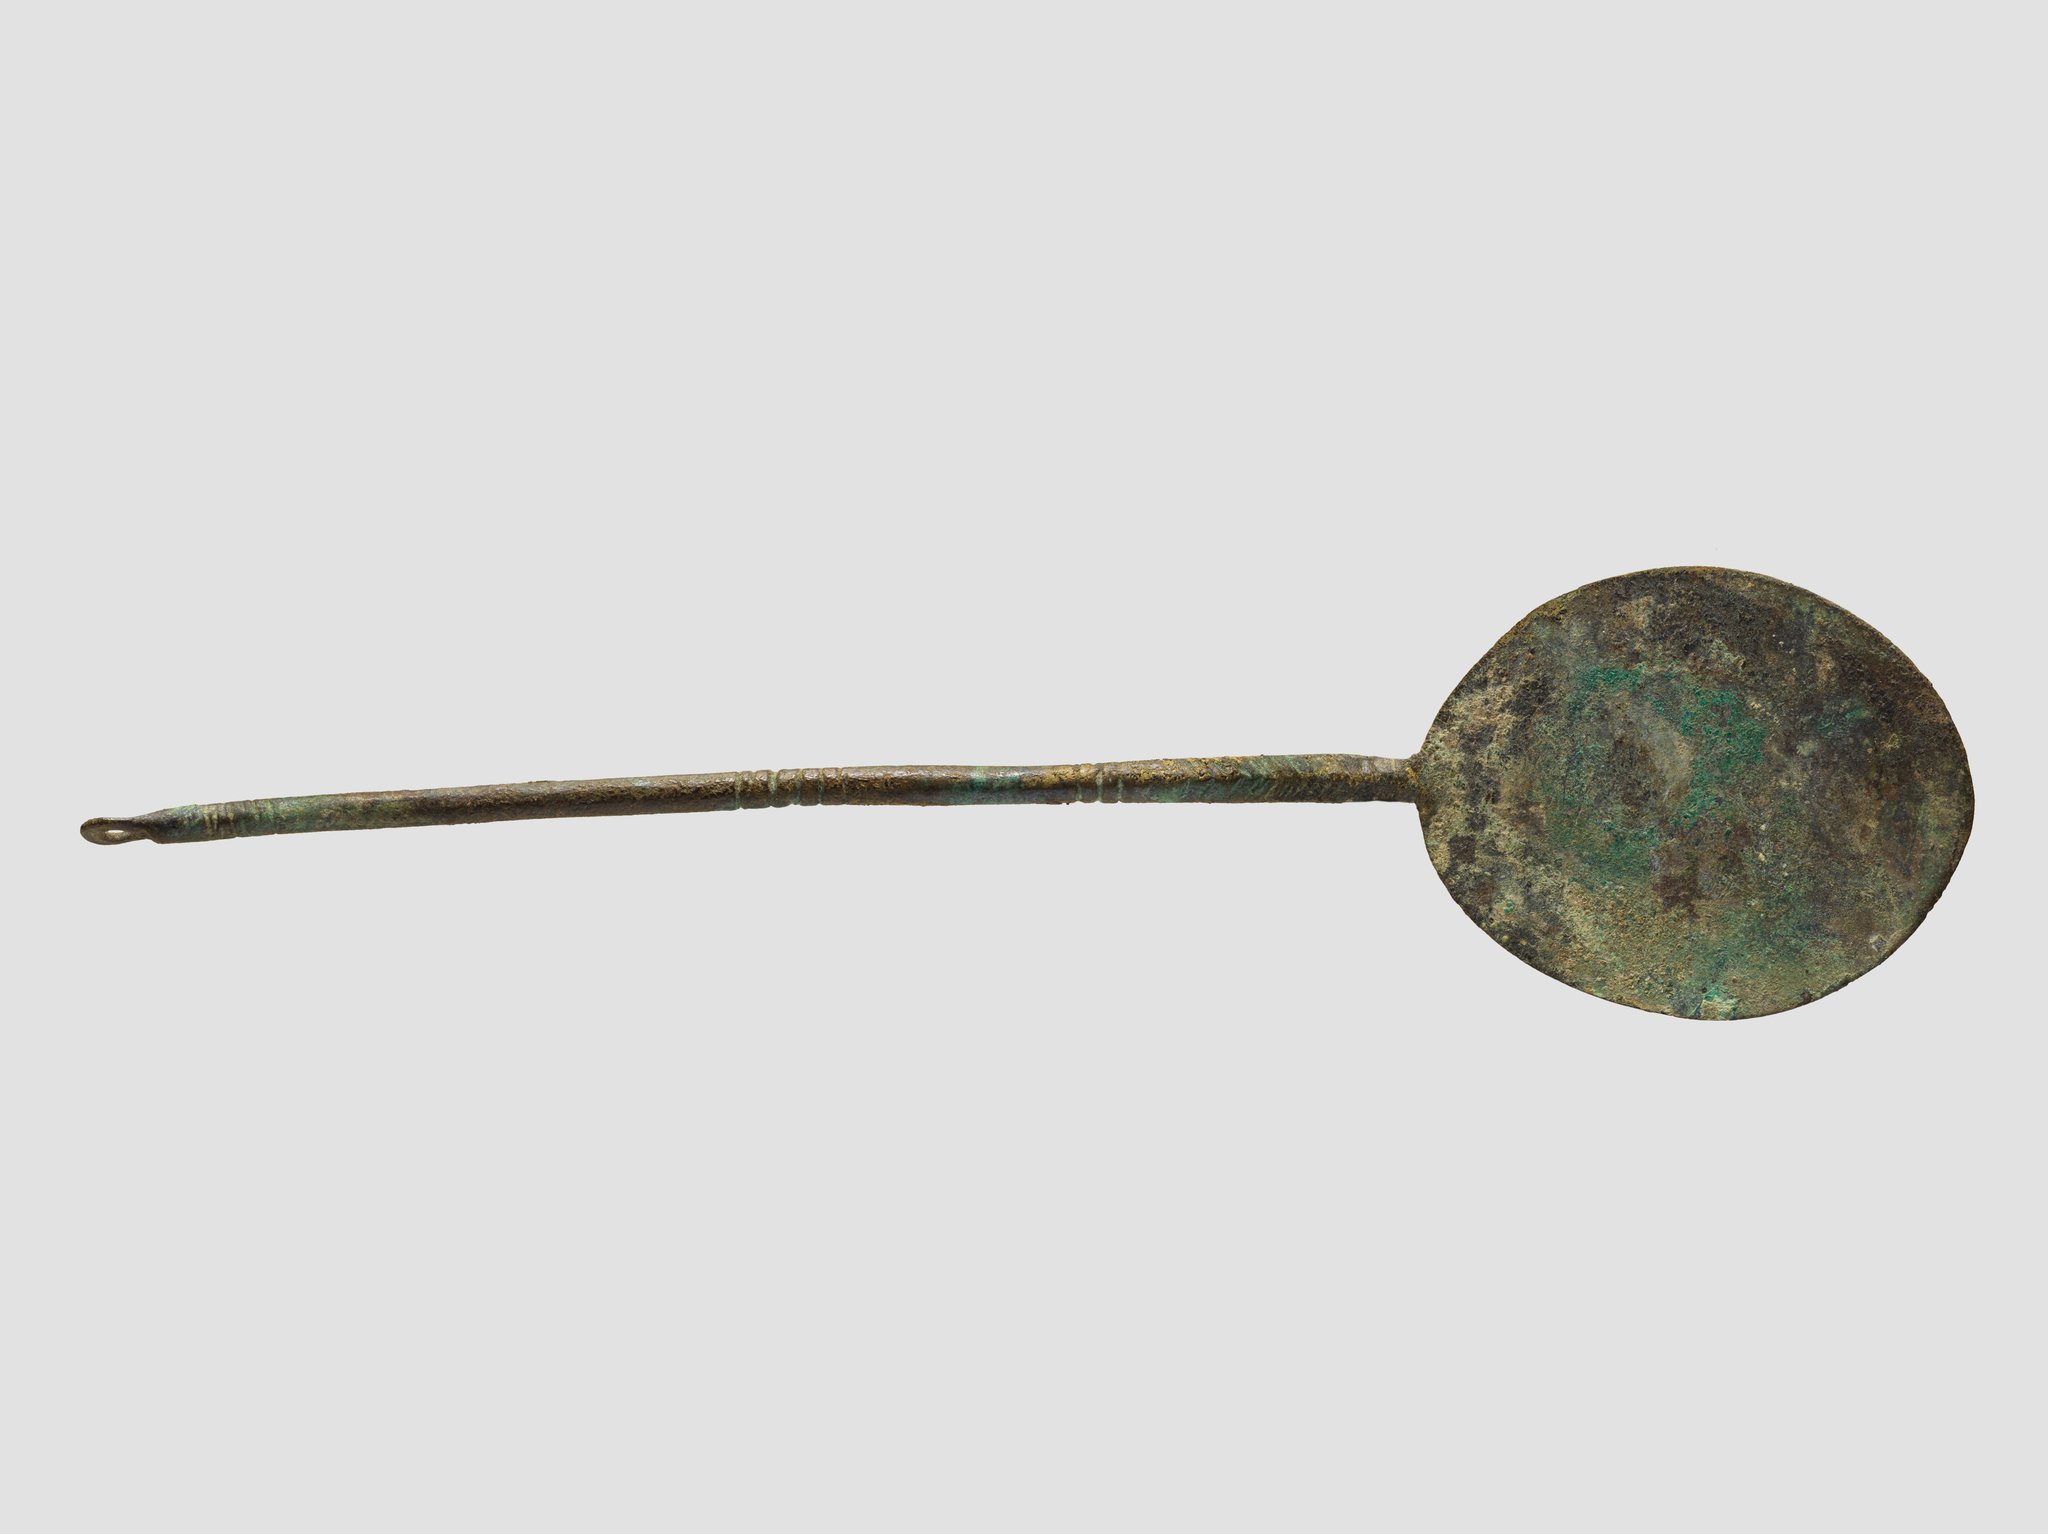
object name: spoon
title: Cosmetic spoon pendant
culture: alanic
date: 601-900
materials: metal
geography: caucasus